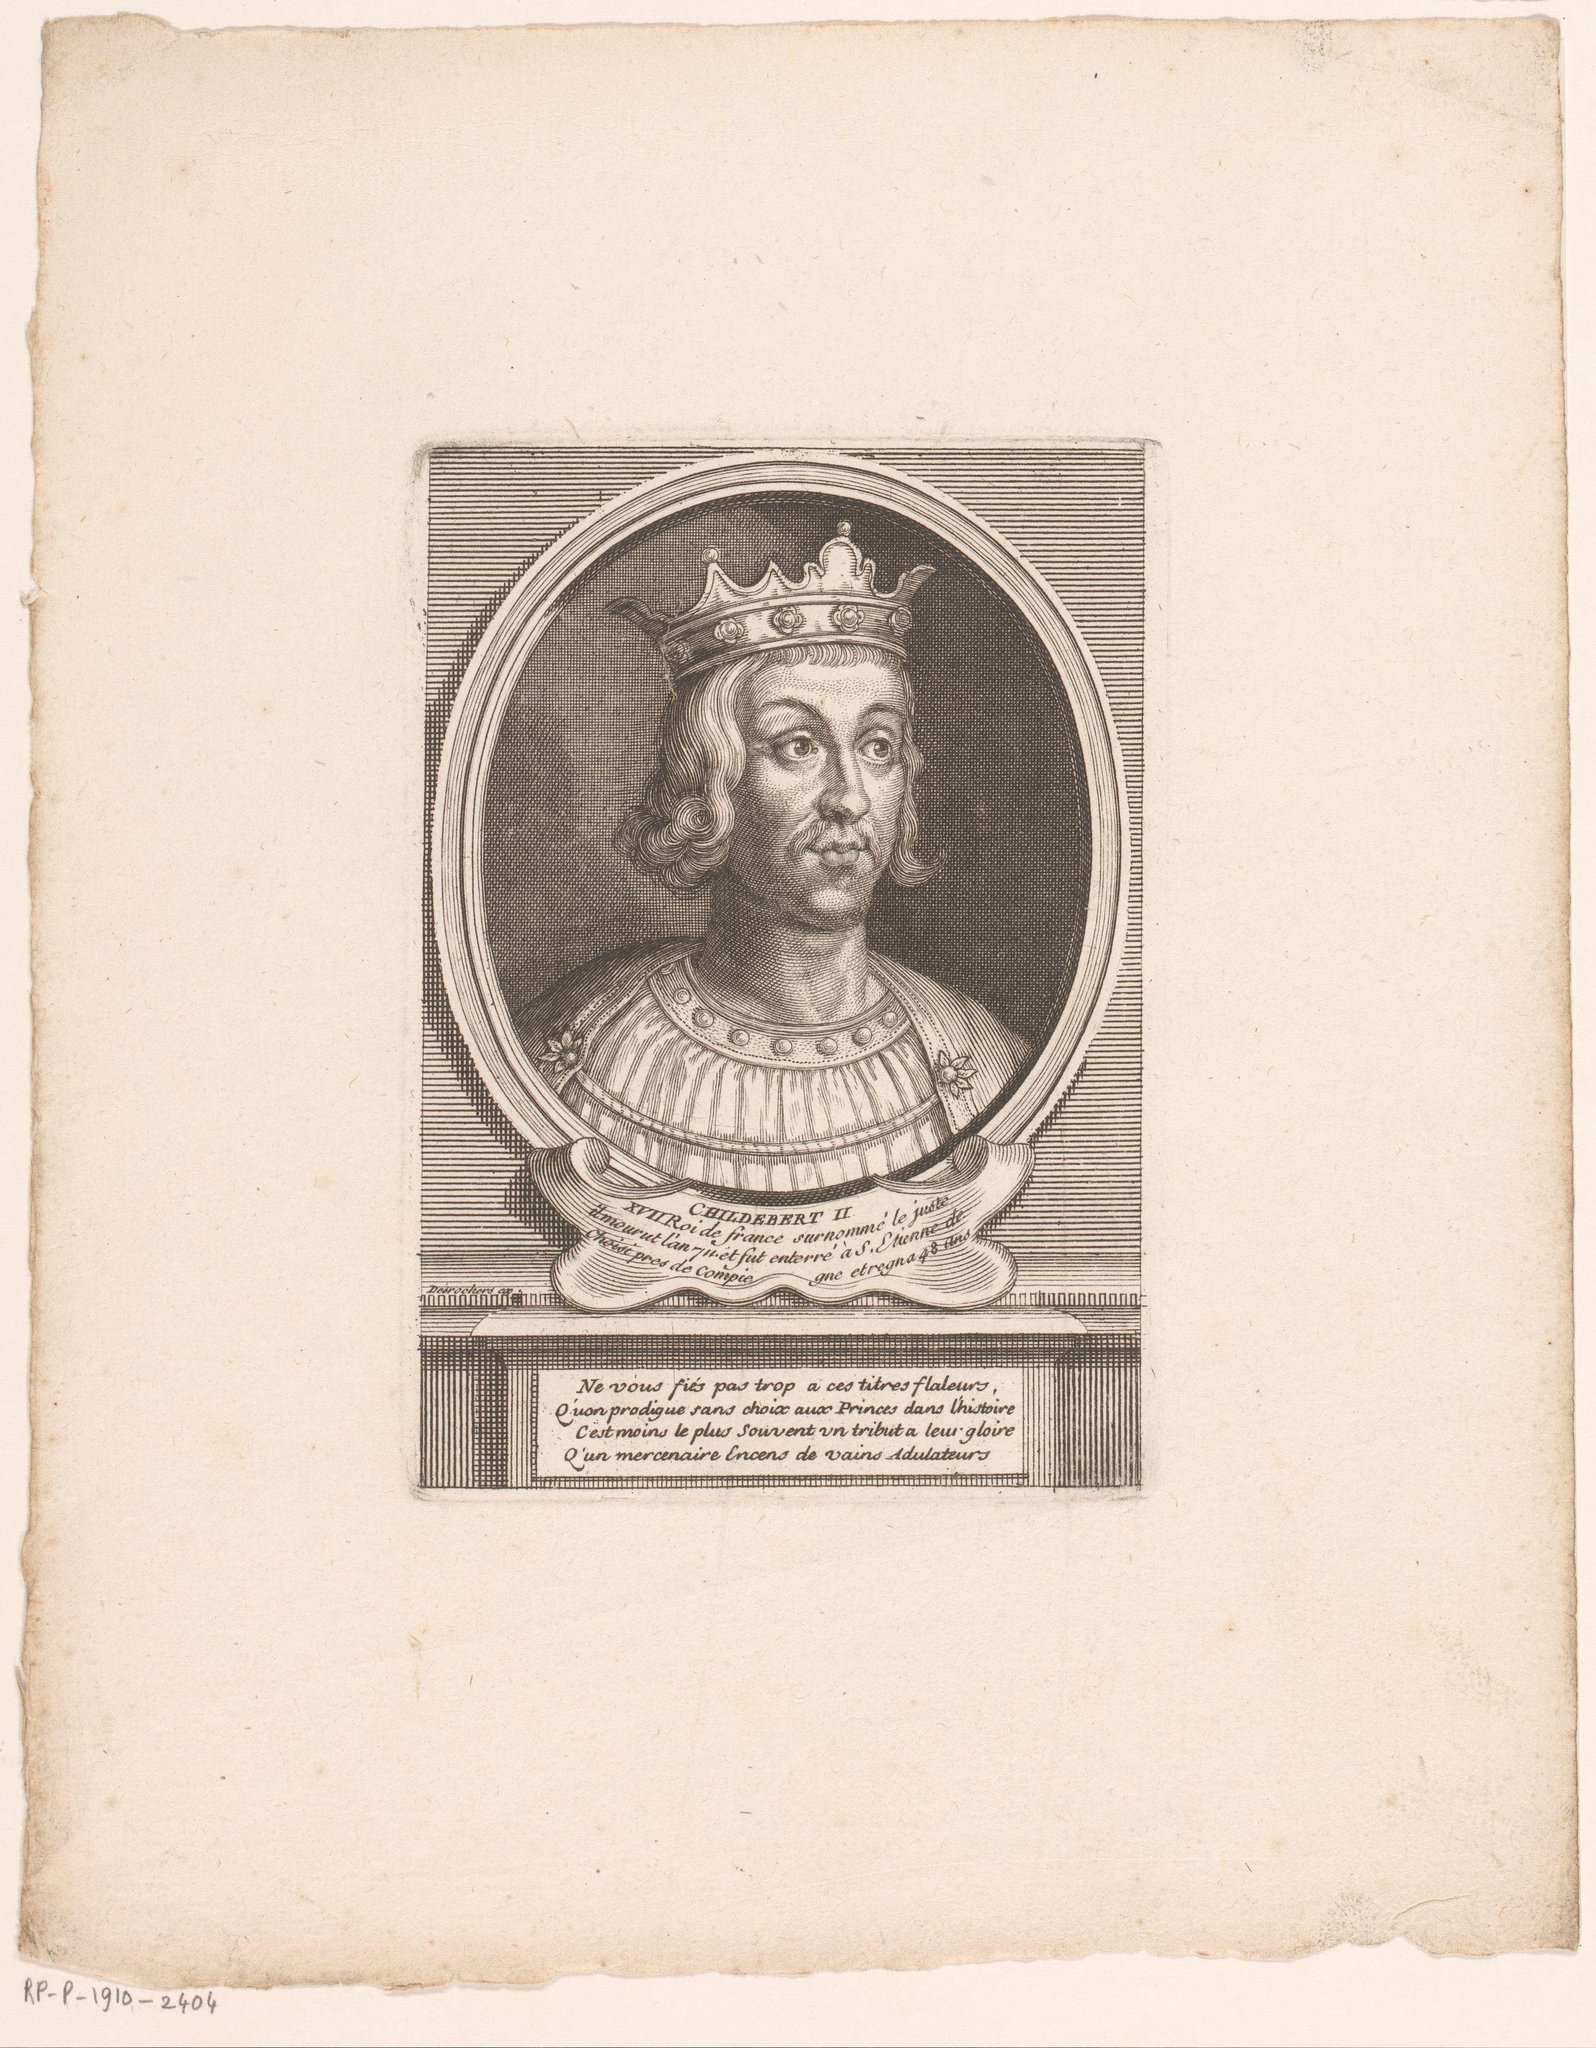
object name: print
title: Recueil de portraits (...)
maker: étienne desrochers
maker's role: print maker, publisher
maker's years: 1668-1741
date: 1726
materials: paper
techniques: engraving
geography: paris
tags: historical persons, king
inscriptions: collector's mark: Lugt 2228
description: Behoort waarschijnlijk tot een serie portretten, grotendeels door Etienne Desrochers, getiteld: 'Recueil de portraits de personnes qui se sont distinguées tant dans les Armes que dans Belles-Lettres et les Arts, comme aussi la famille royale de France et autres cours étrangères'. De serie werd initieel uitgegeven door Desrochers en aangekondigd in 'Mercure' in mei 1726, p. 985. Echter was Desrochers reeds enkele jaren eerder begonnen met het uitgeven van de serie. Na de dood van Desrochers werd de serie voortgezet door Gilles Edme Petit. Een latere staat werd uitgegeven door Jean François Daumont in Parijs.